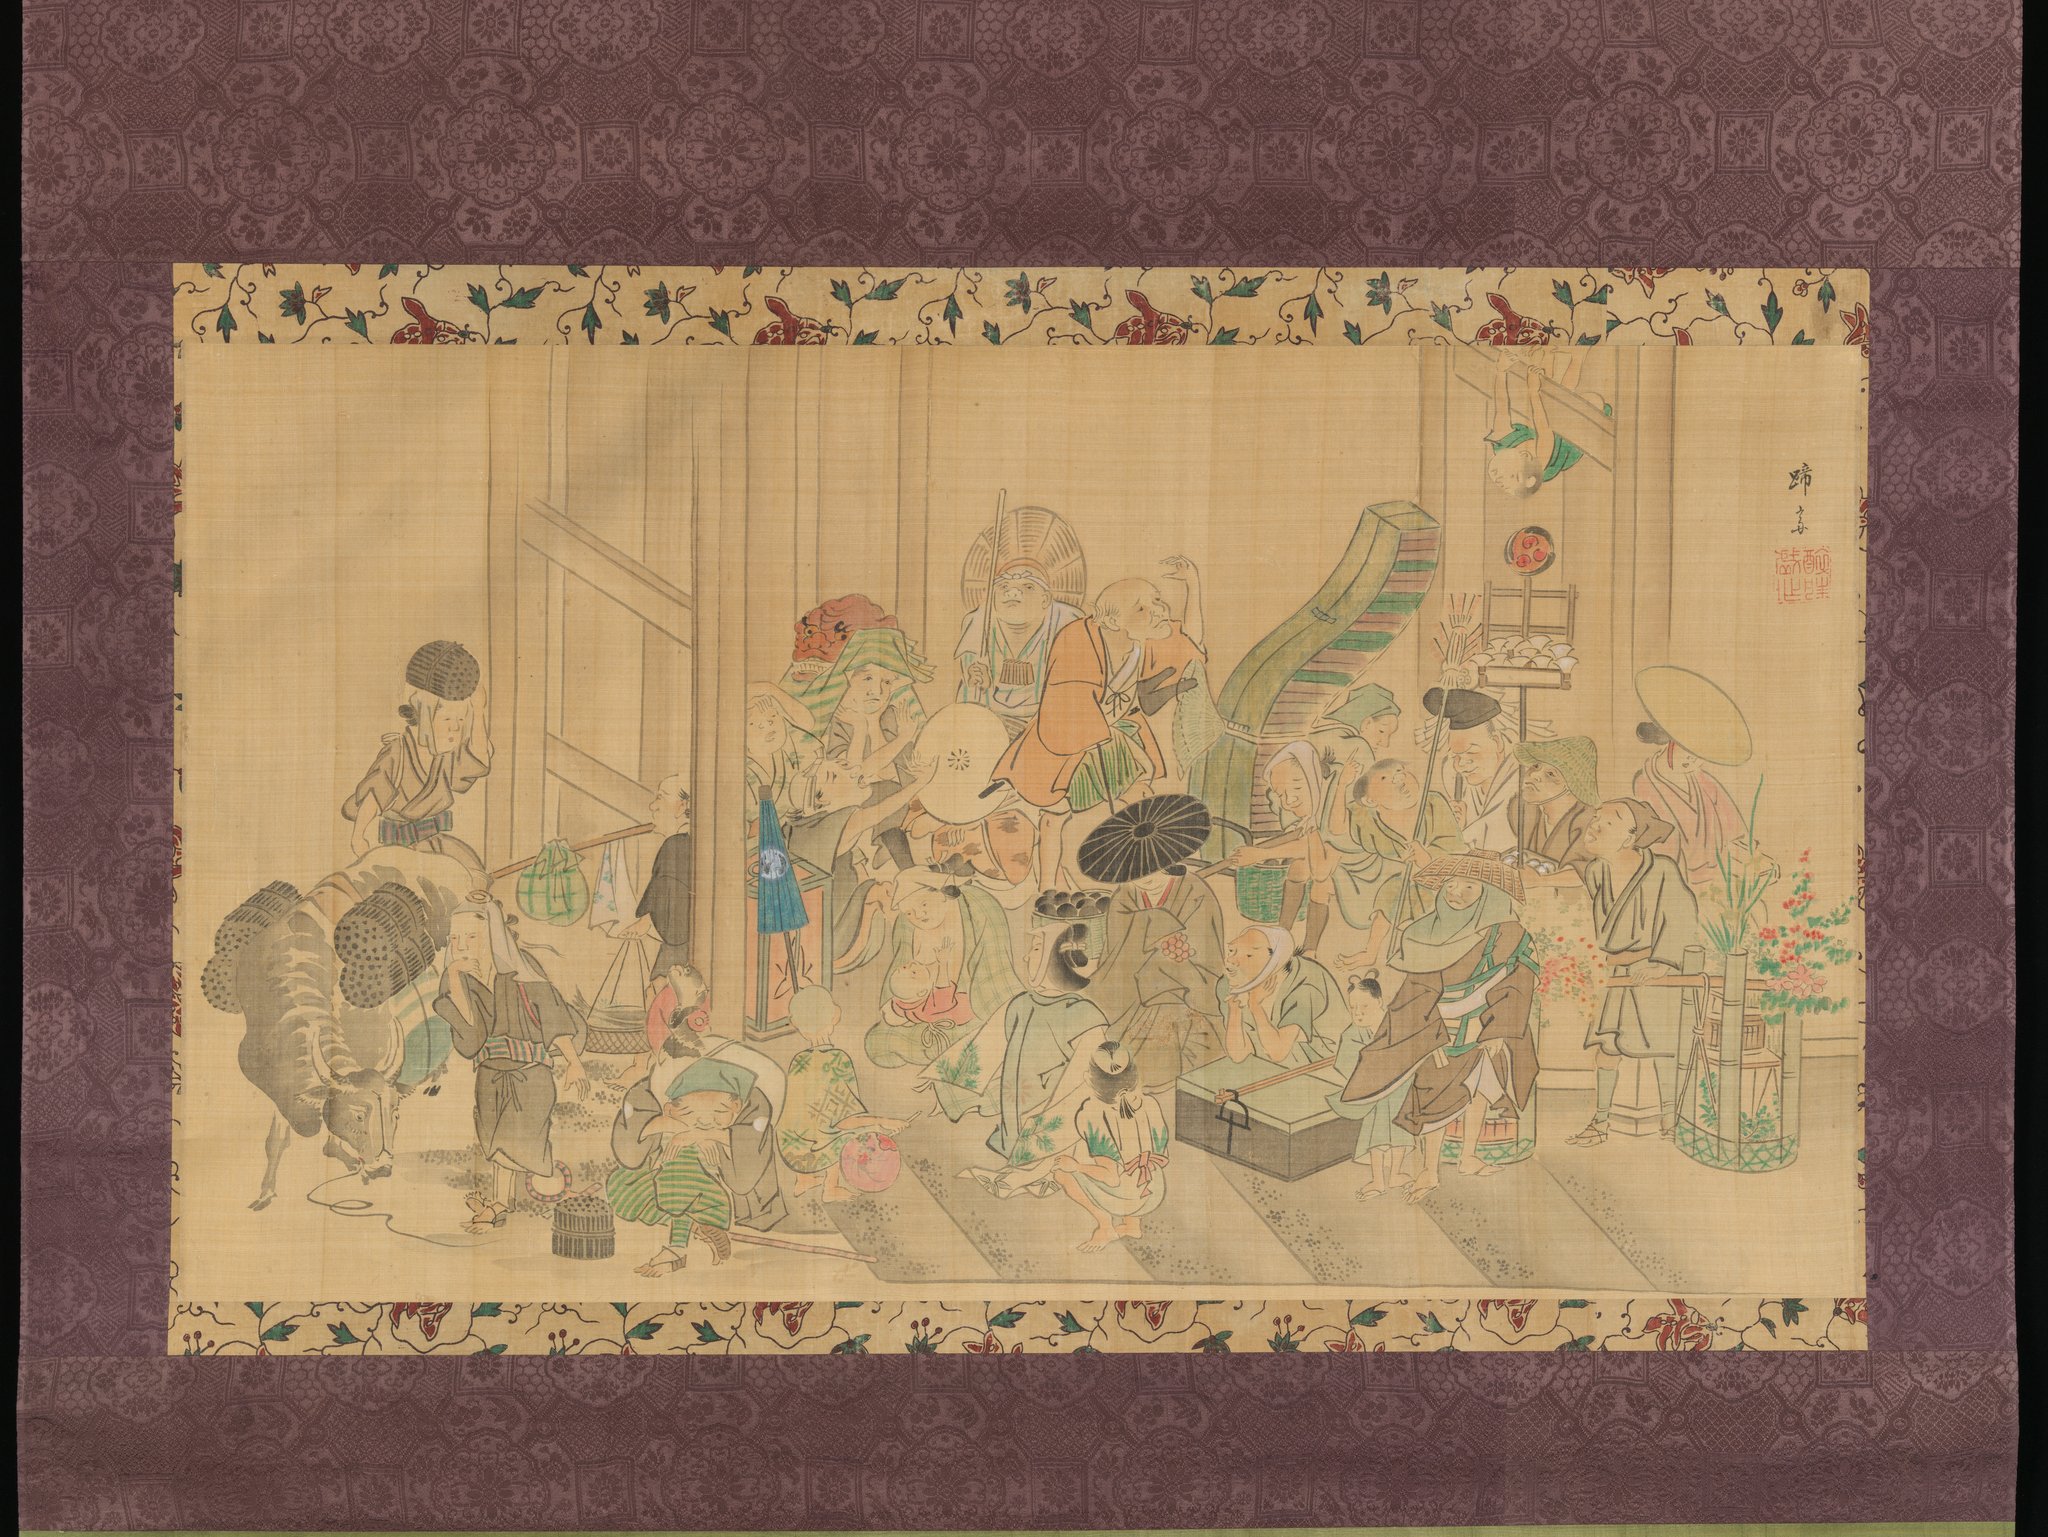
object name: hanging scroll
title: Taking Shelter from the Rain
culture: japanese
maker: teisai hokuba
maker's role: artist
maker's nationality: japanese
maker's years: 1771-1844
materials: ink, silk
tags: children,men,women,ox